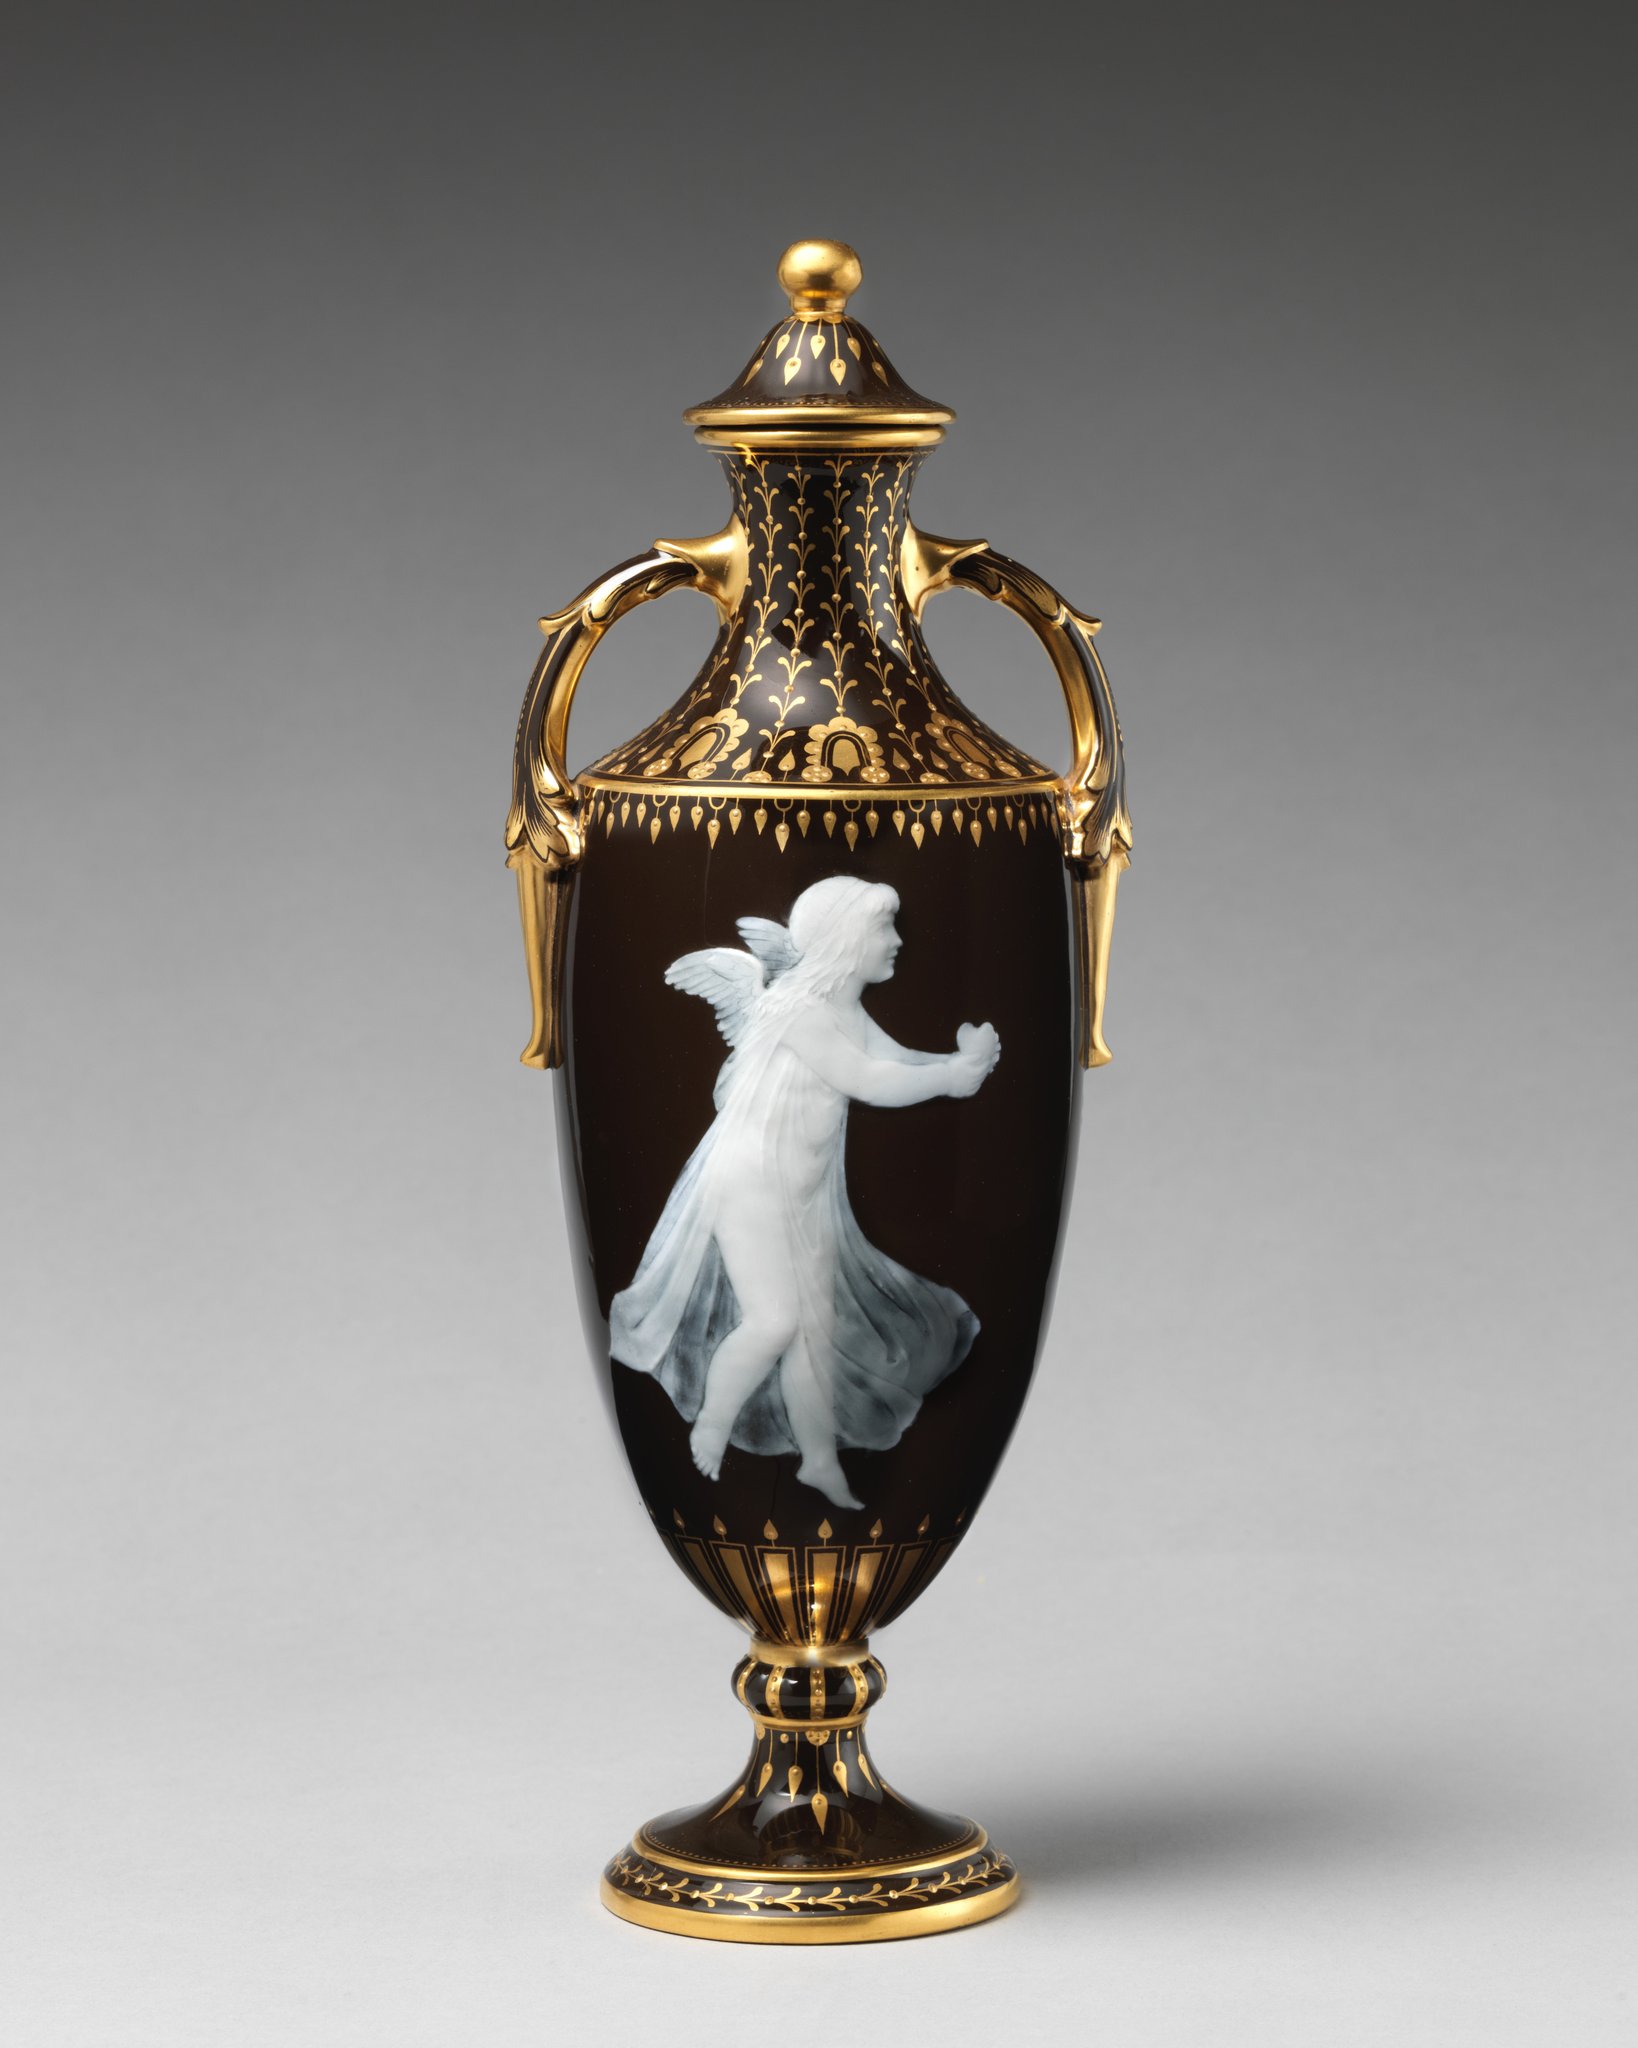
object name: vase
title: The Half and The Whole (one of a pair)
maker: minton(s)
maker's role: maker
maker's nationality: british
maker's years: 1793-2001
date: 1895-1899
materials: bone china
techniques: gilding